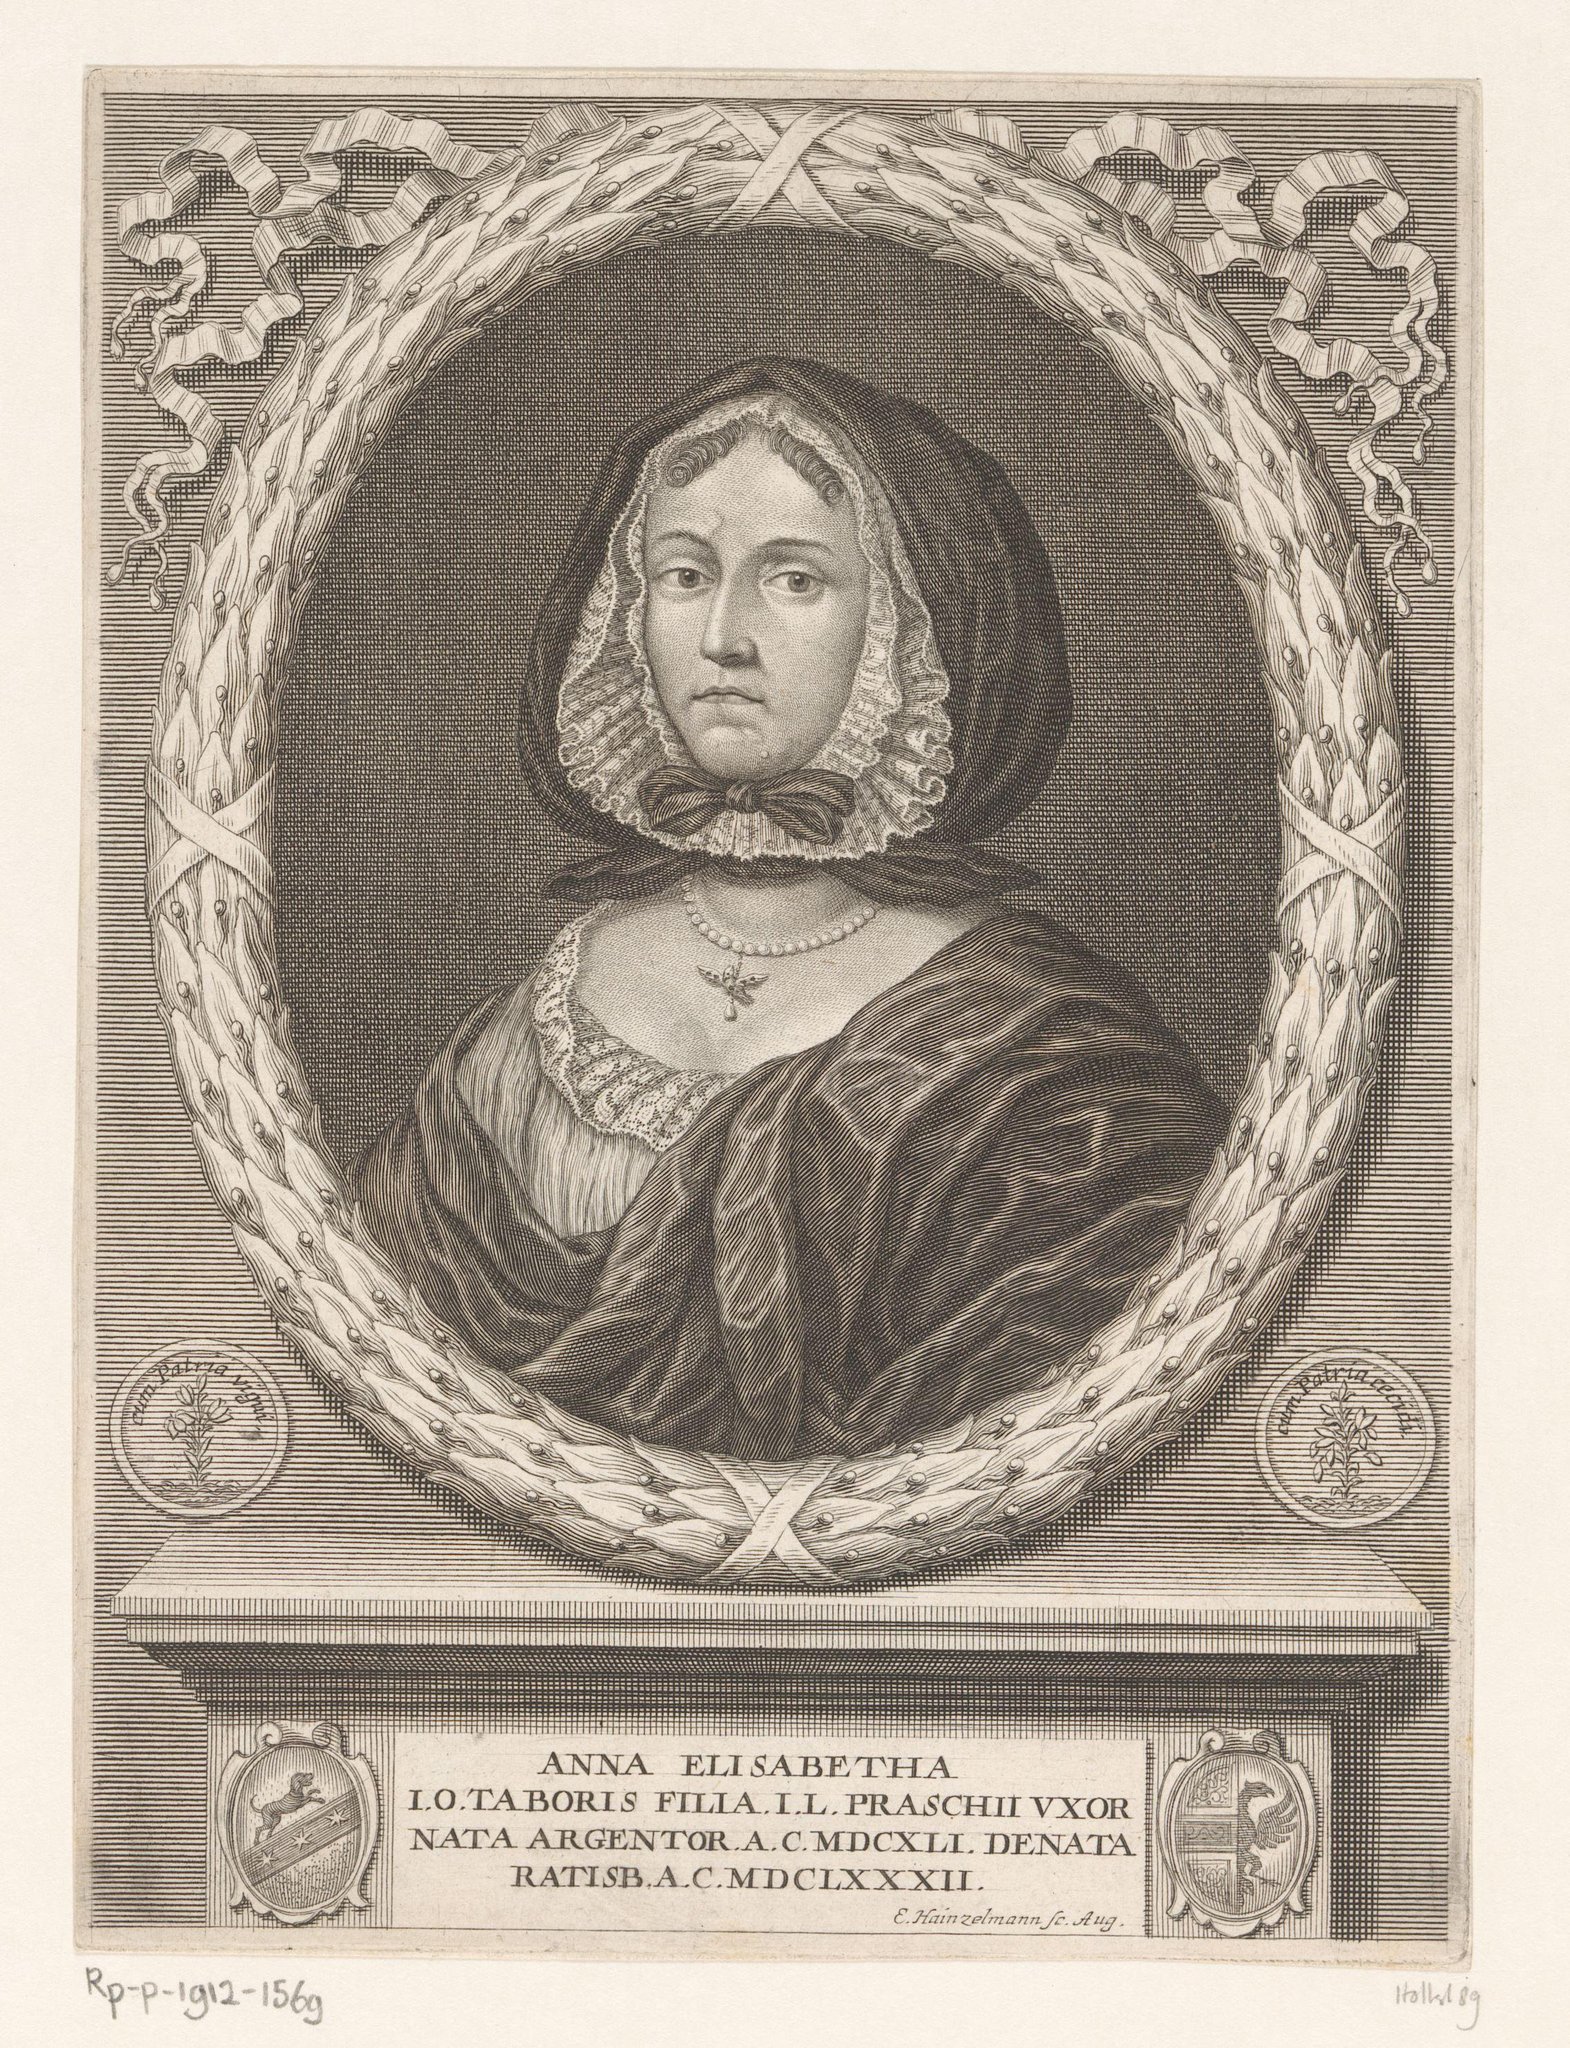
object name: print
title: Portret van Susanna Elisabeth Tabor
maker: elias hainzelmann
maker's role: artist, print maker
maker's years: 1640-1693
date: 1682-1693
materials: paper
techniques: engraving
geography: augsburg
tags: historical persons - bb - woman, pendant, trinket, 'breloque', abstract ideas and concepts (+ emblematical representation of concept), armorial bearing, heraldry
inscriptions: collector's mark: Lugt 2228